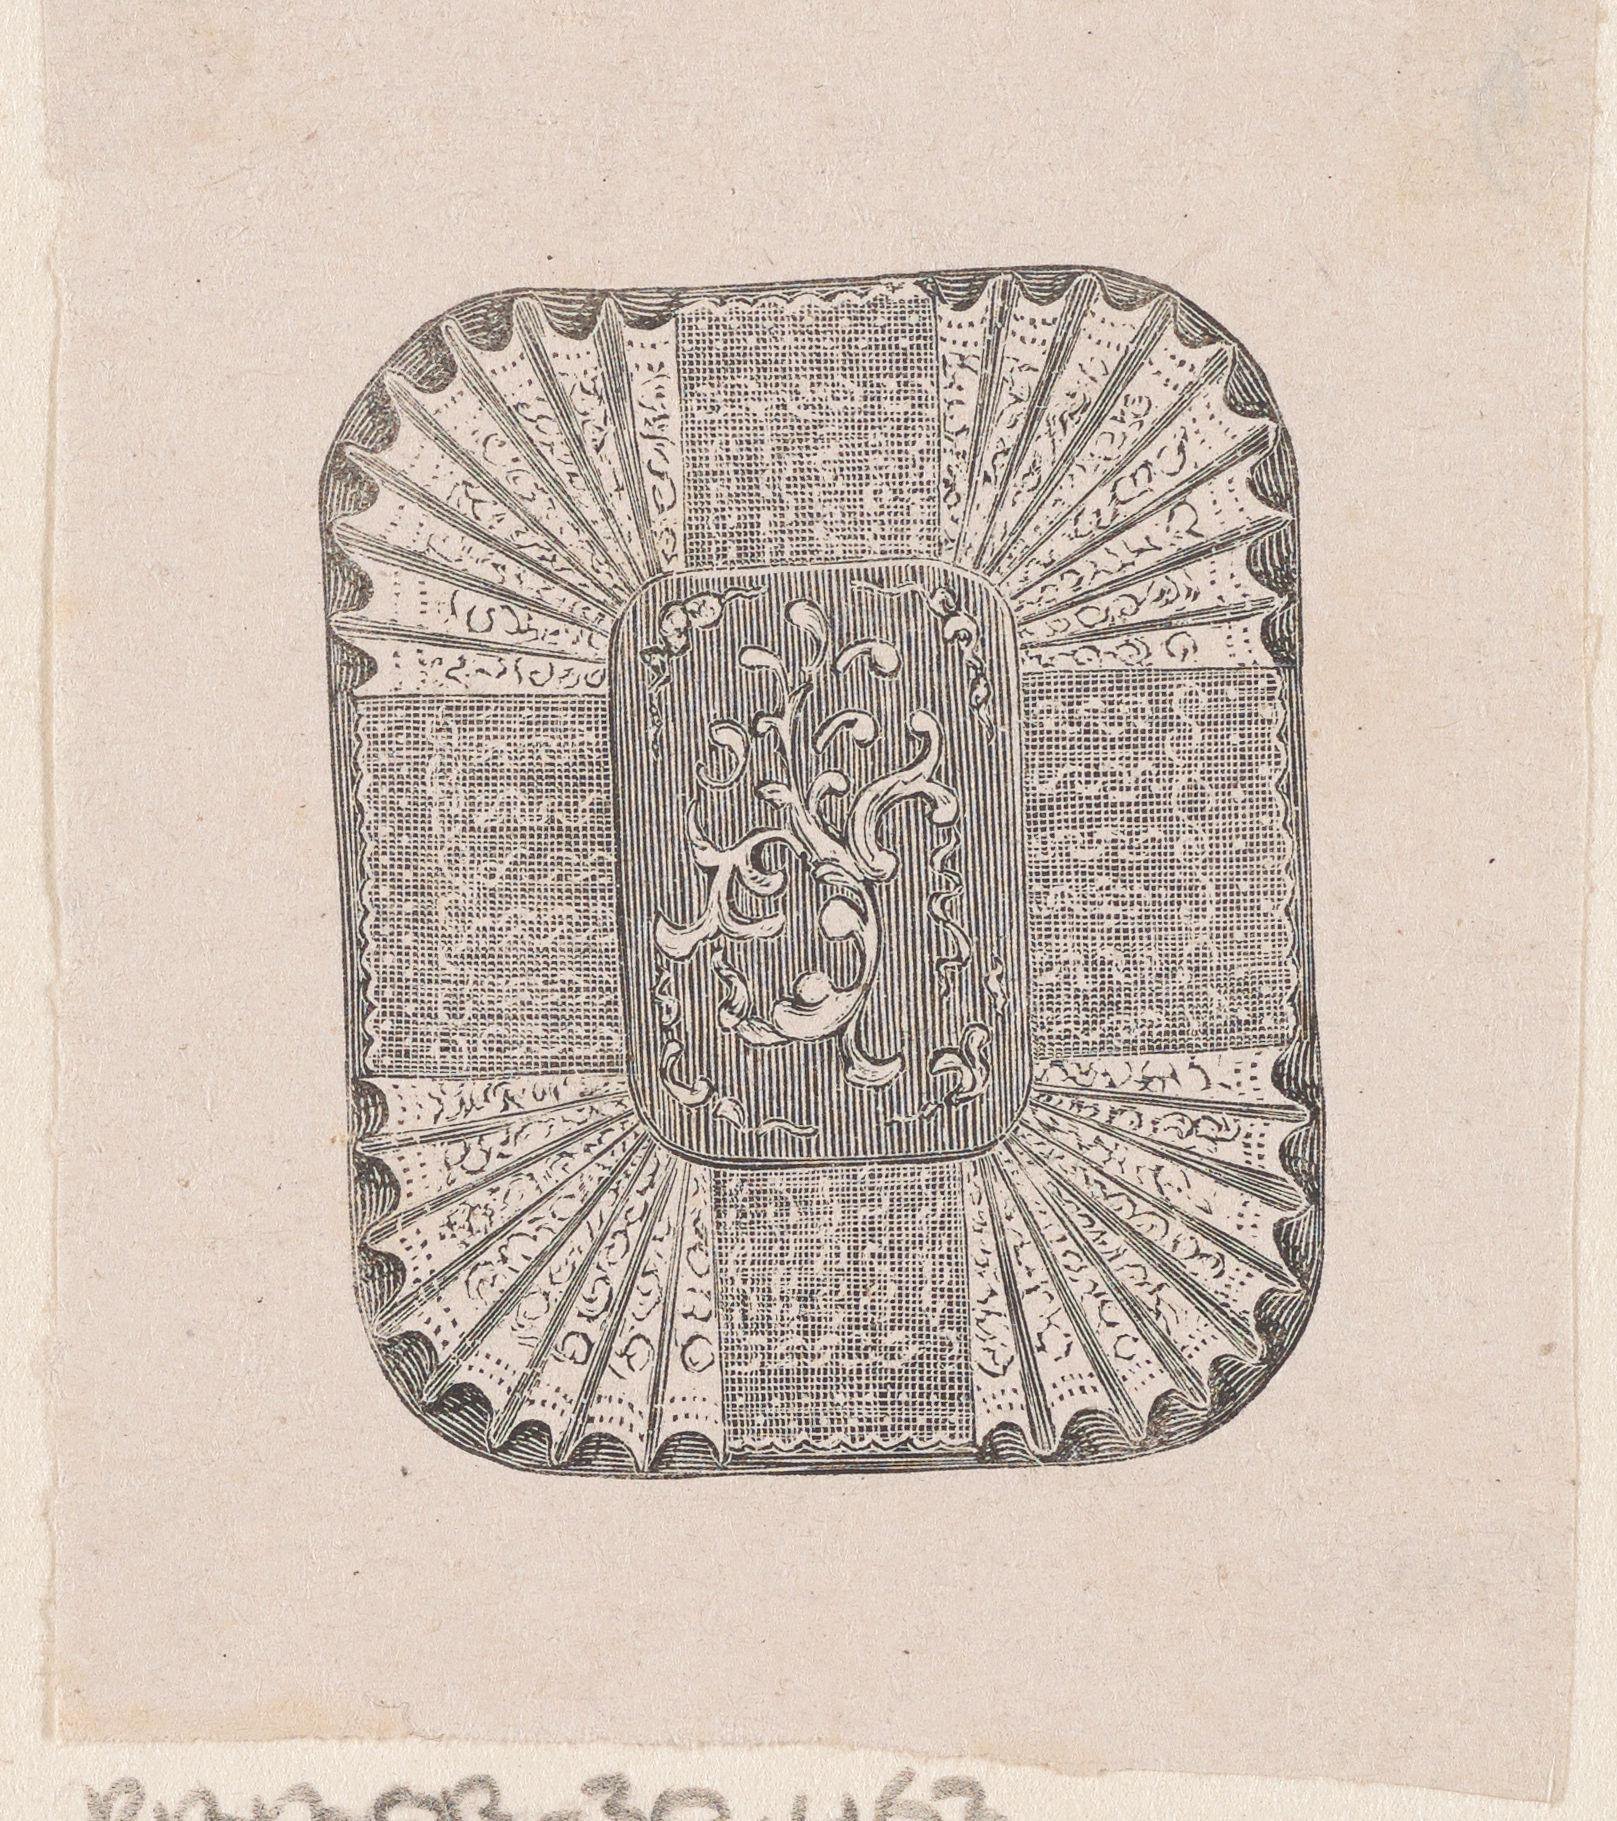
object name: print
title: Vignet met ornamenten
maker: isaac weissenbruch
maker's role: print maker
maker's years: 1826-1912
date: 1836-1912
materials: paper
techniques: engraving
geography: netherlands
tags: ornaments ~ art, vignette